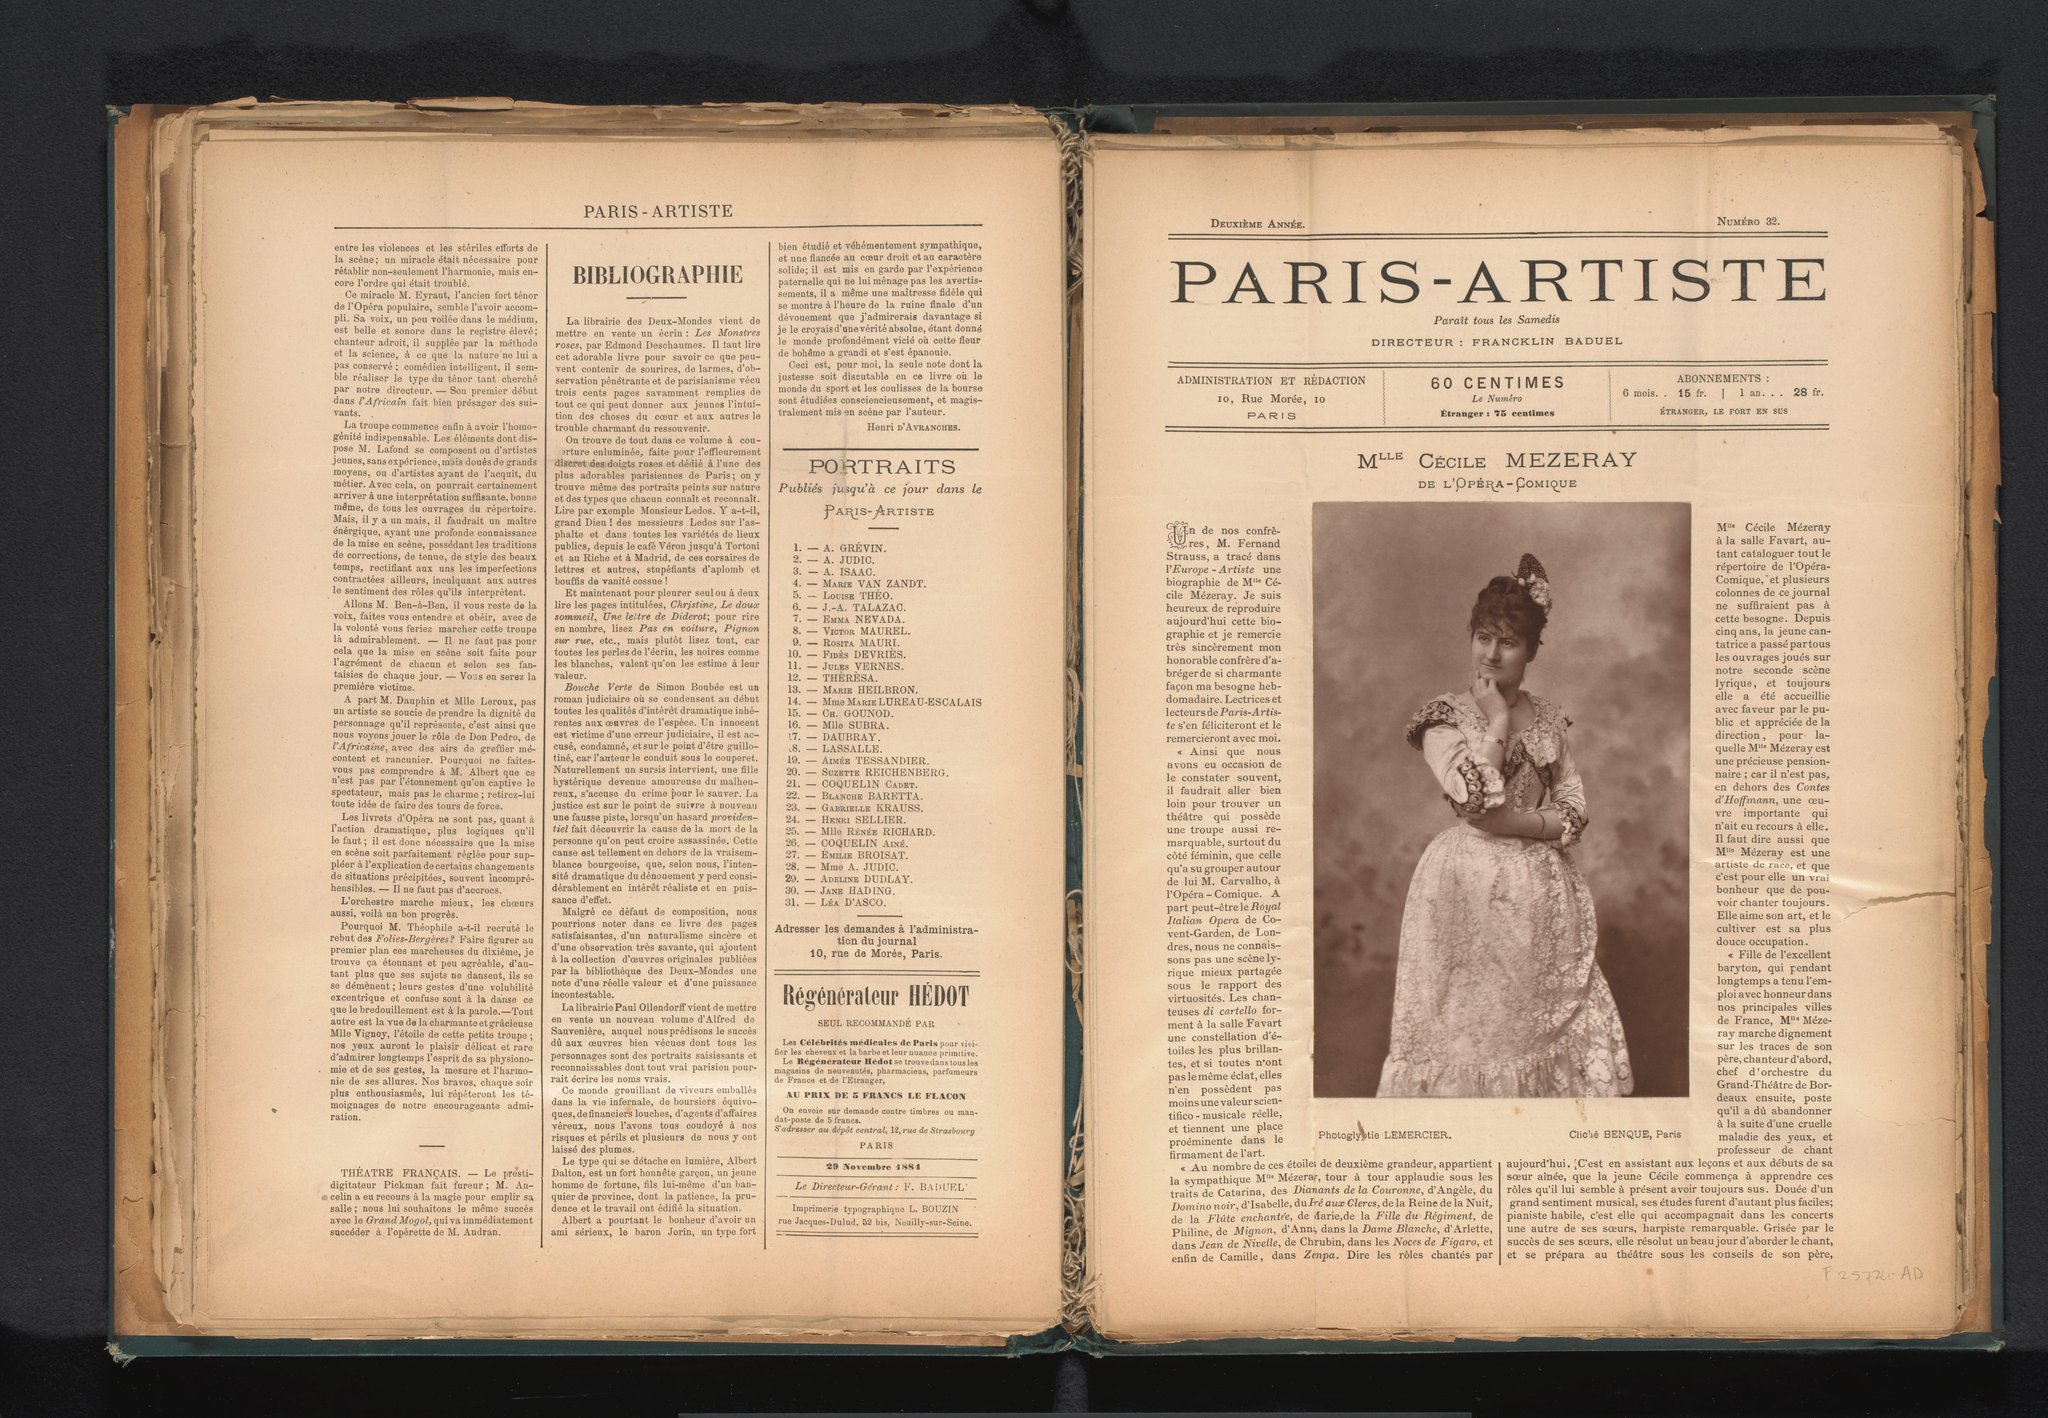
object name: page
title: Portret van Cécile Mezeray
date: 1875-1884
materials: paper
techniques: woodburytype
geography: paris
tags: historical persons - bb - woman, opera-singer (female)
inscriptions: inscription: ‘De l'Opéra-Comique’